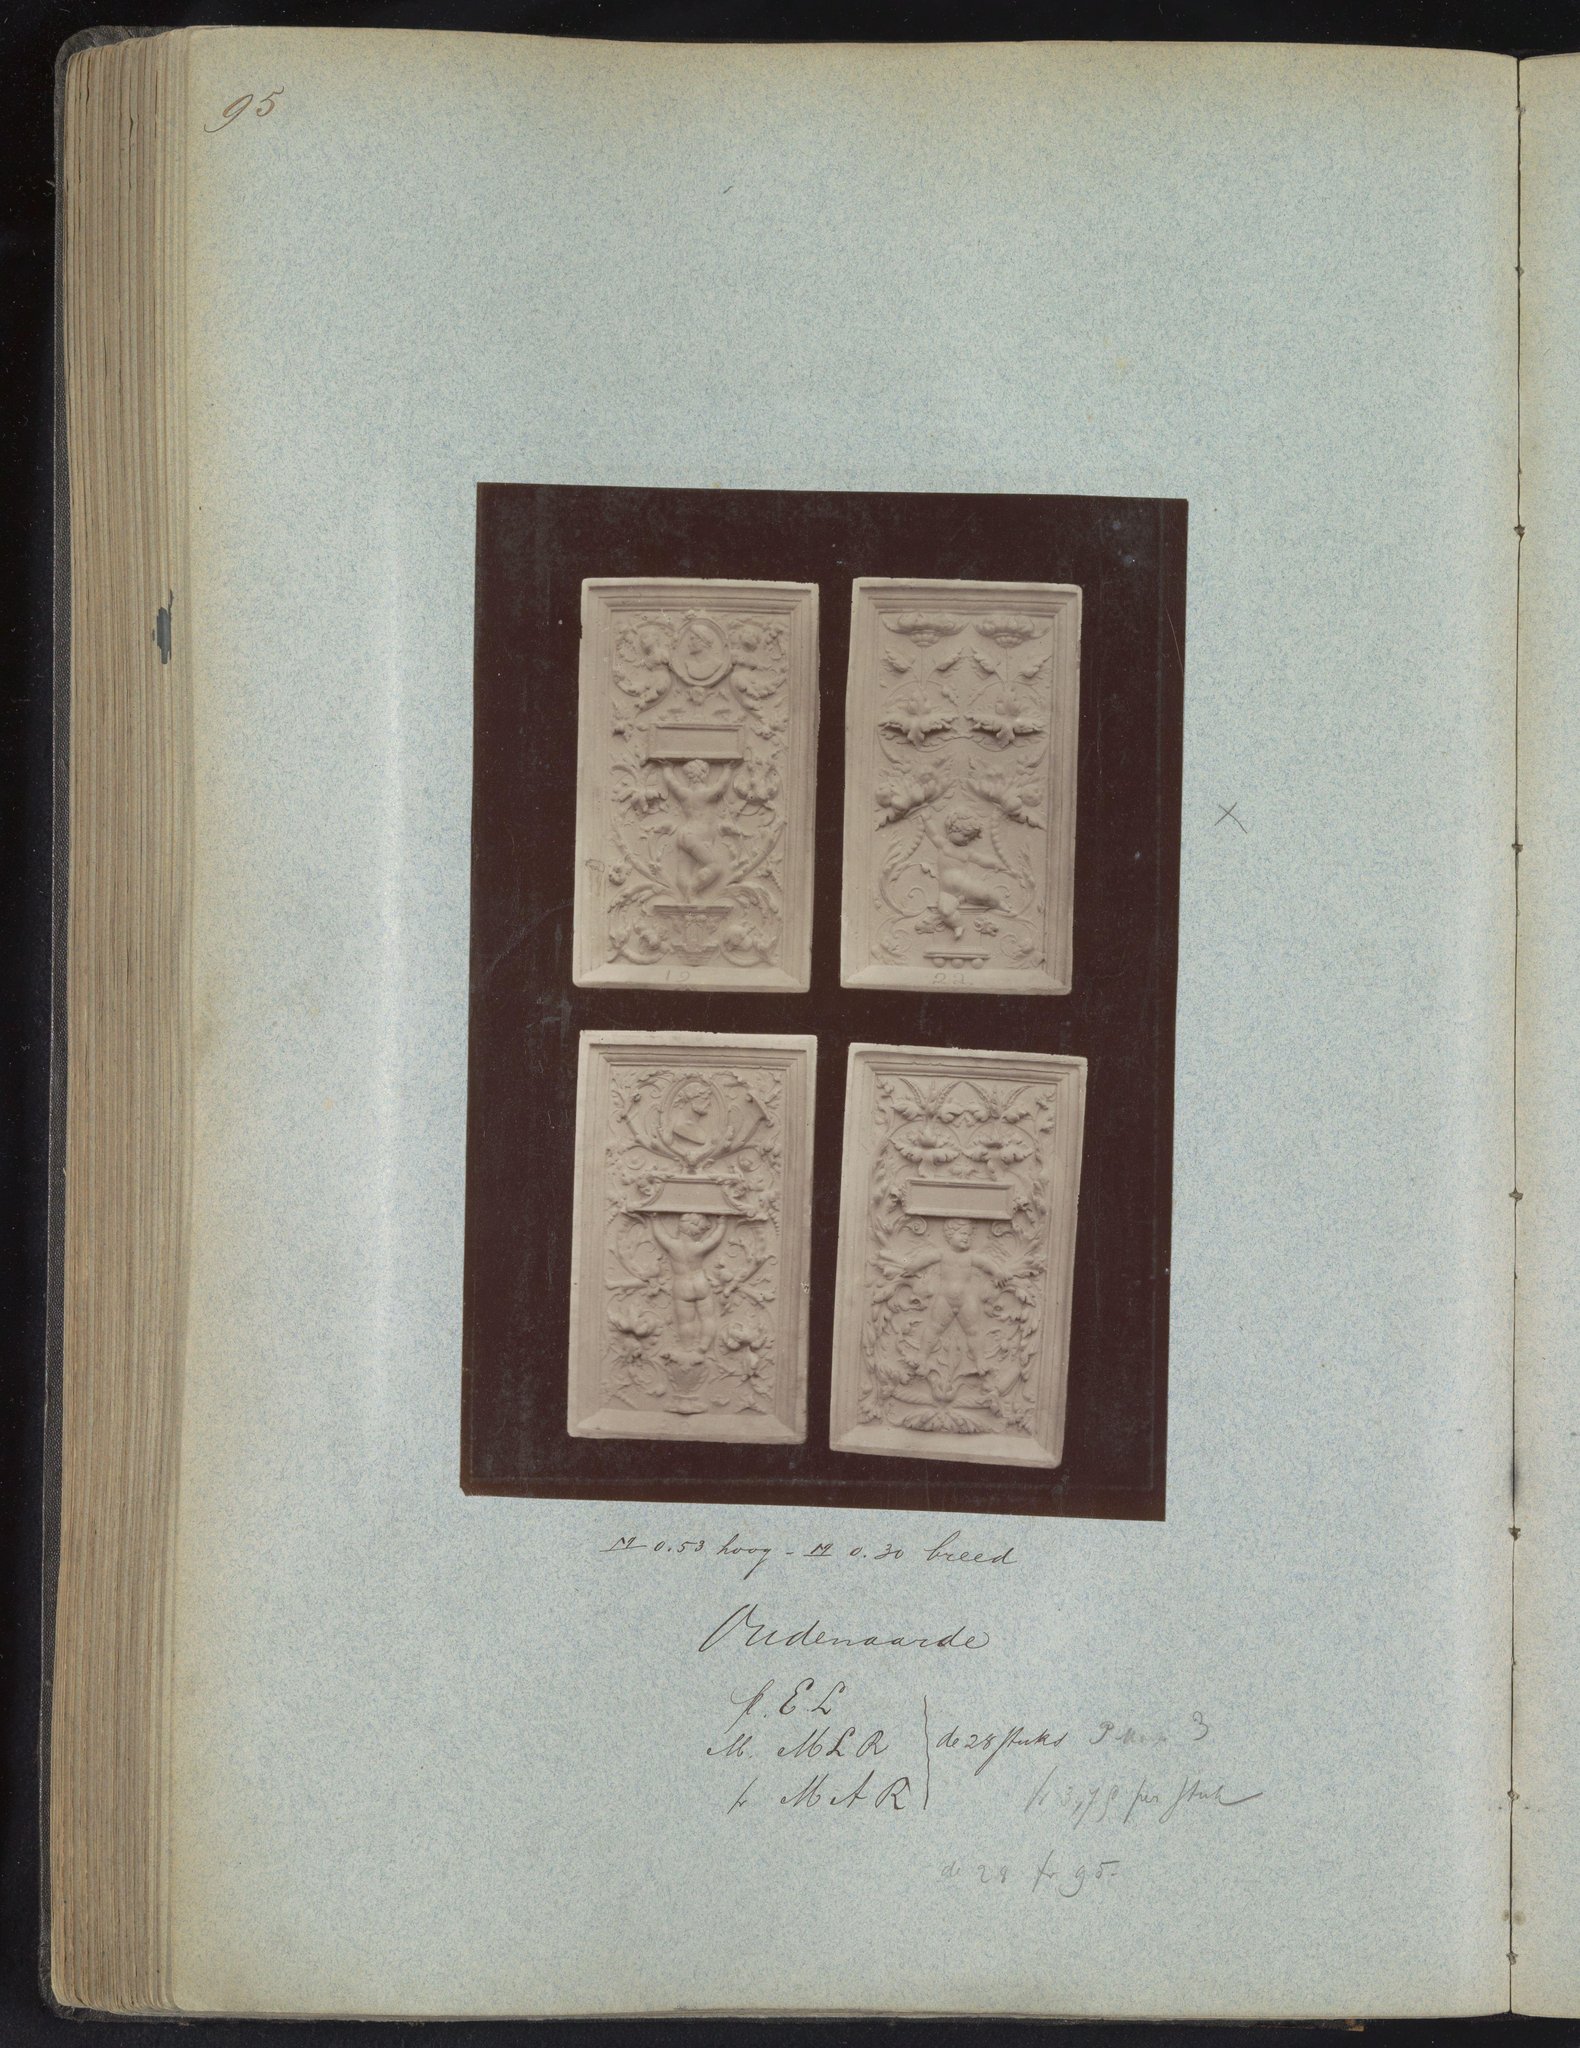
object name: album leaf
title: Vier gipsen afgietsels van panelen, vermoedelijk afkomstig uit Oudenaarde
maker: Anonymous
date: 1875-1900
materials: paper, photographic support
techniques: albumen print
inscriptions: annotation, annotation: ‘M 0.53 hoog - M 0.30 breed’, annotation: ‘Oudenaarde’